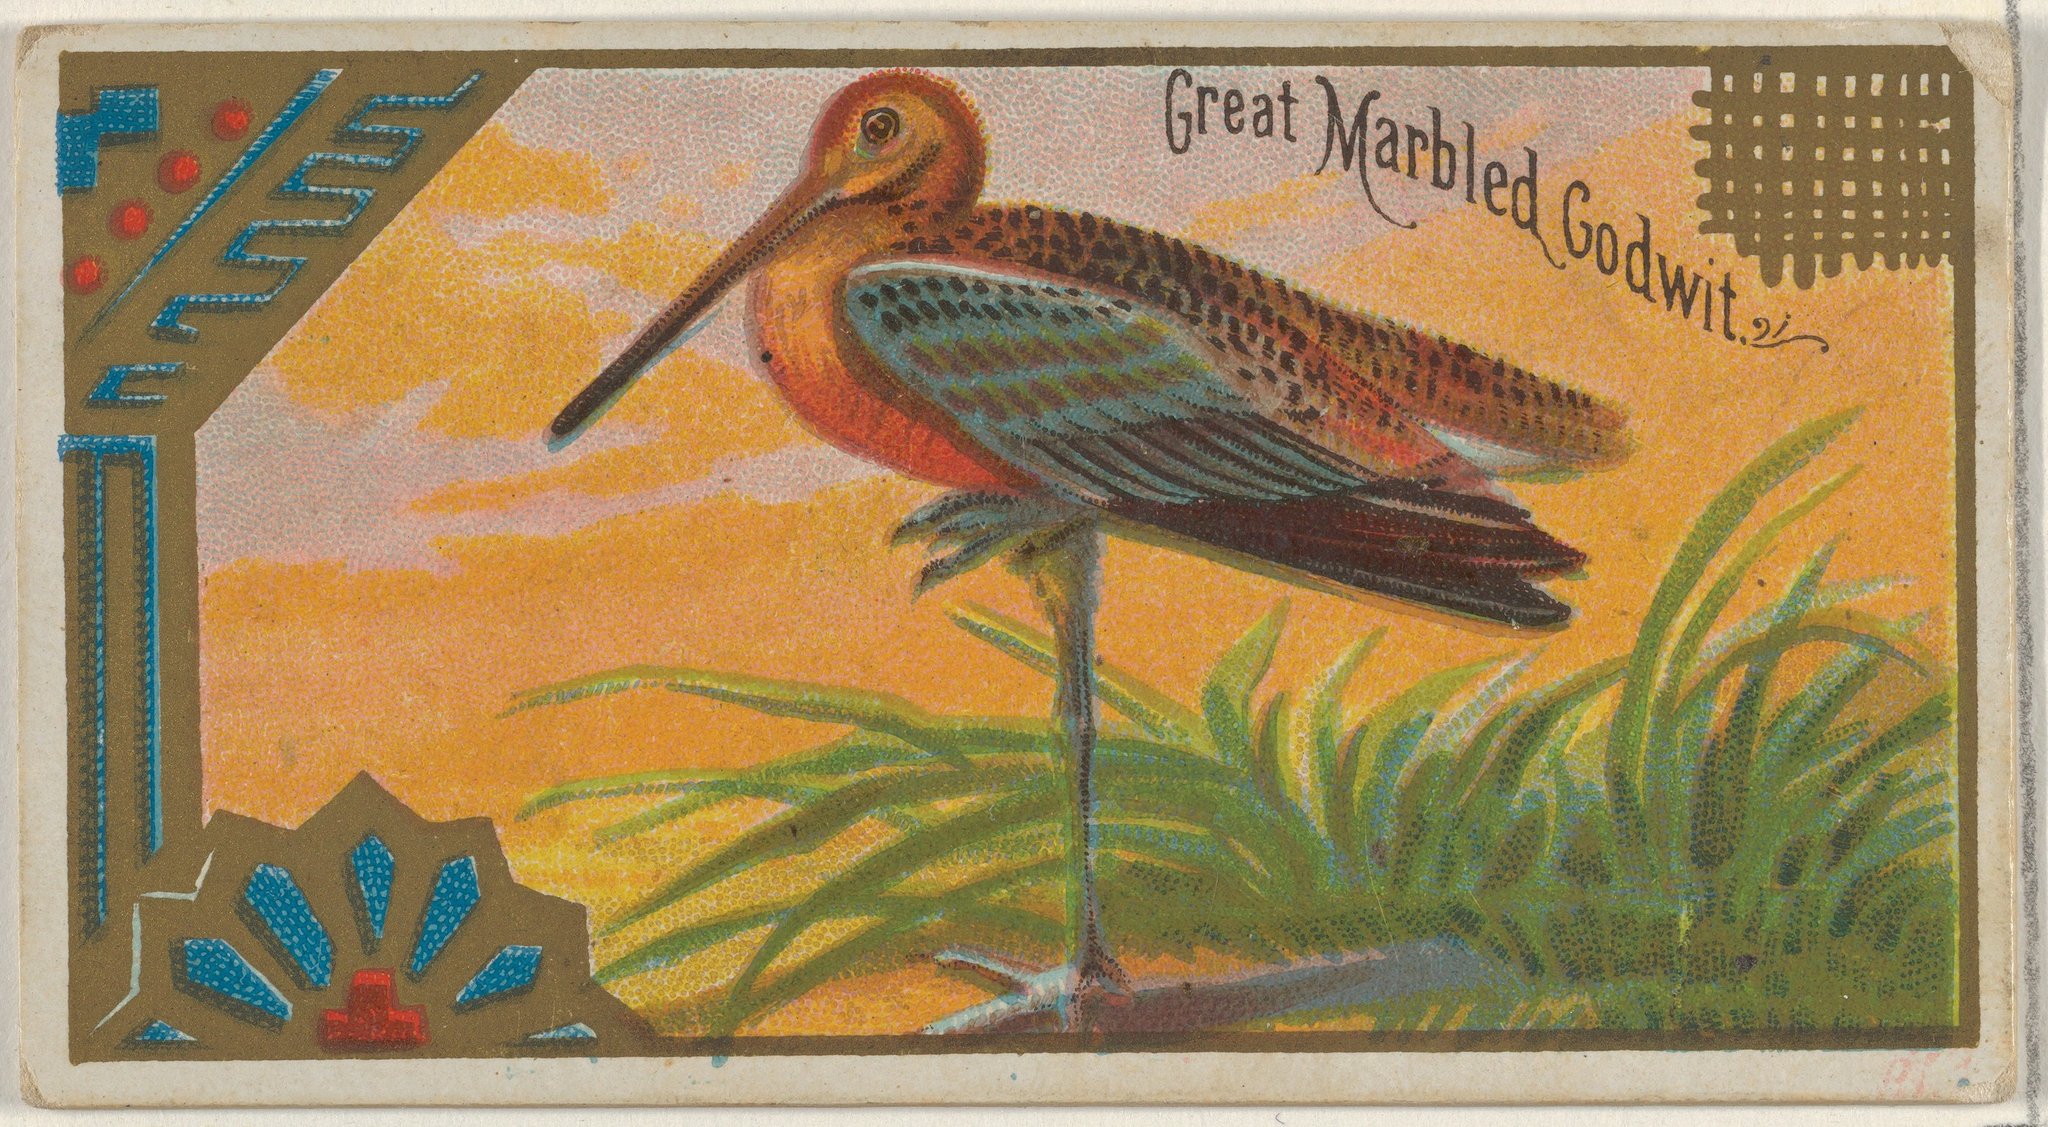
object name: print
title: Great Marbled Godwit, from the Game Birds series (N13) for Allen & Ginter Cigarettes Brands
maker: allen & ginter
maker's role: publisher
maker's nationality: american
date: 1889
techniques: color lithograph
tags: birds